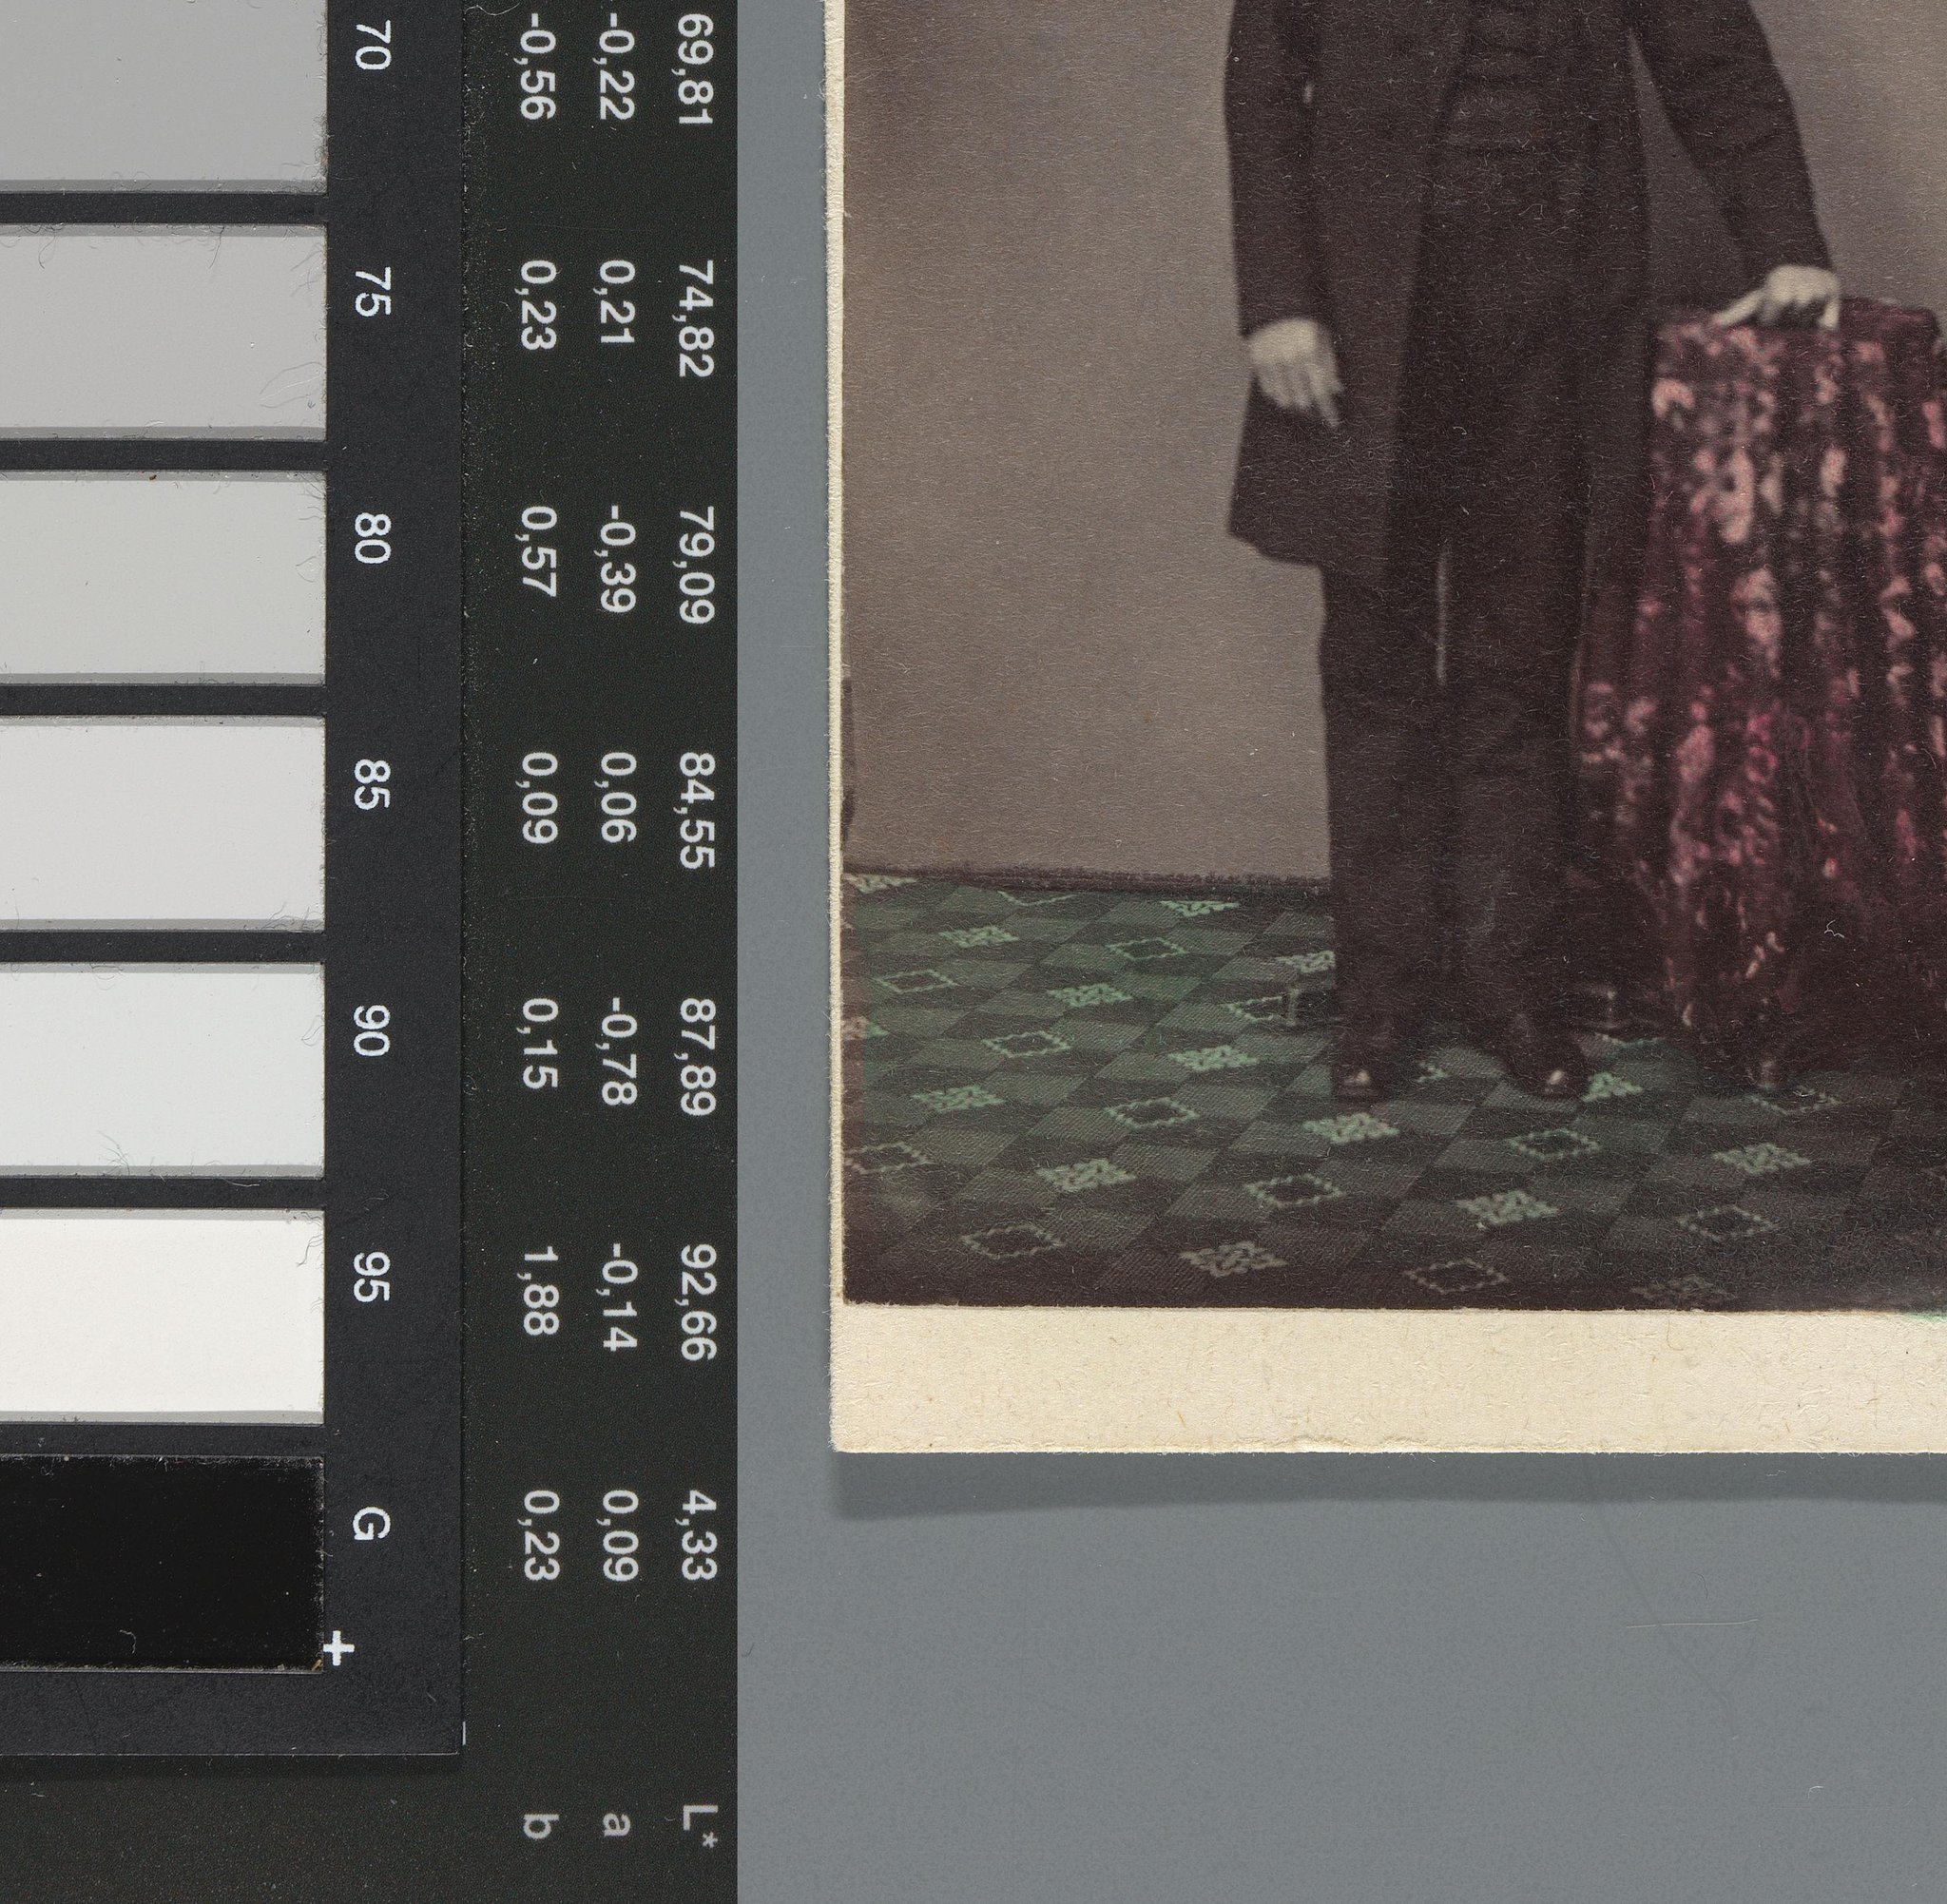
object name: carte de visite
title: Portret van een onbekende man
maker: p.w.h. deshler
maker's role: fotograaf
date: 1865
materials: photographic support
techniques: albumen print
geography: allentown